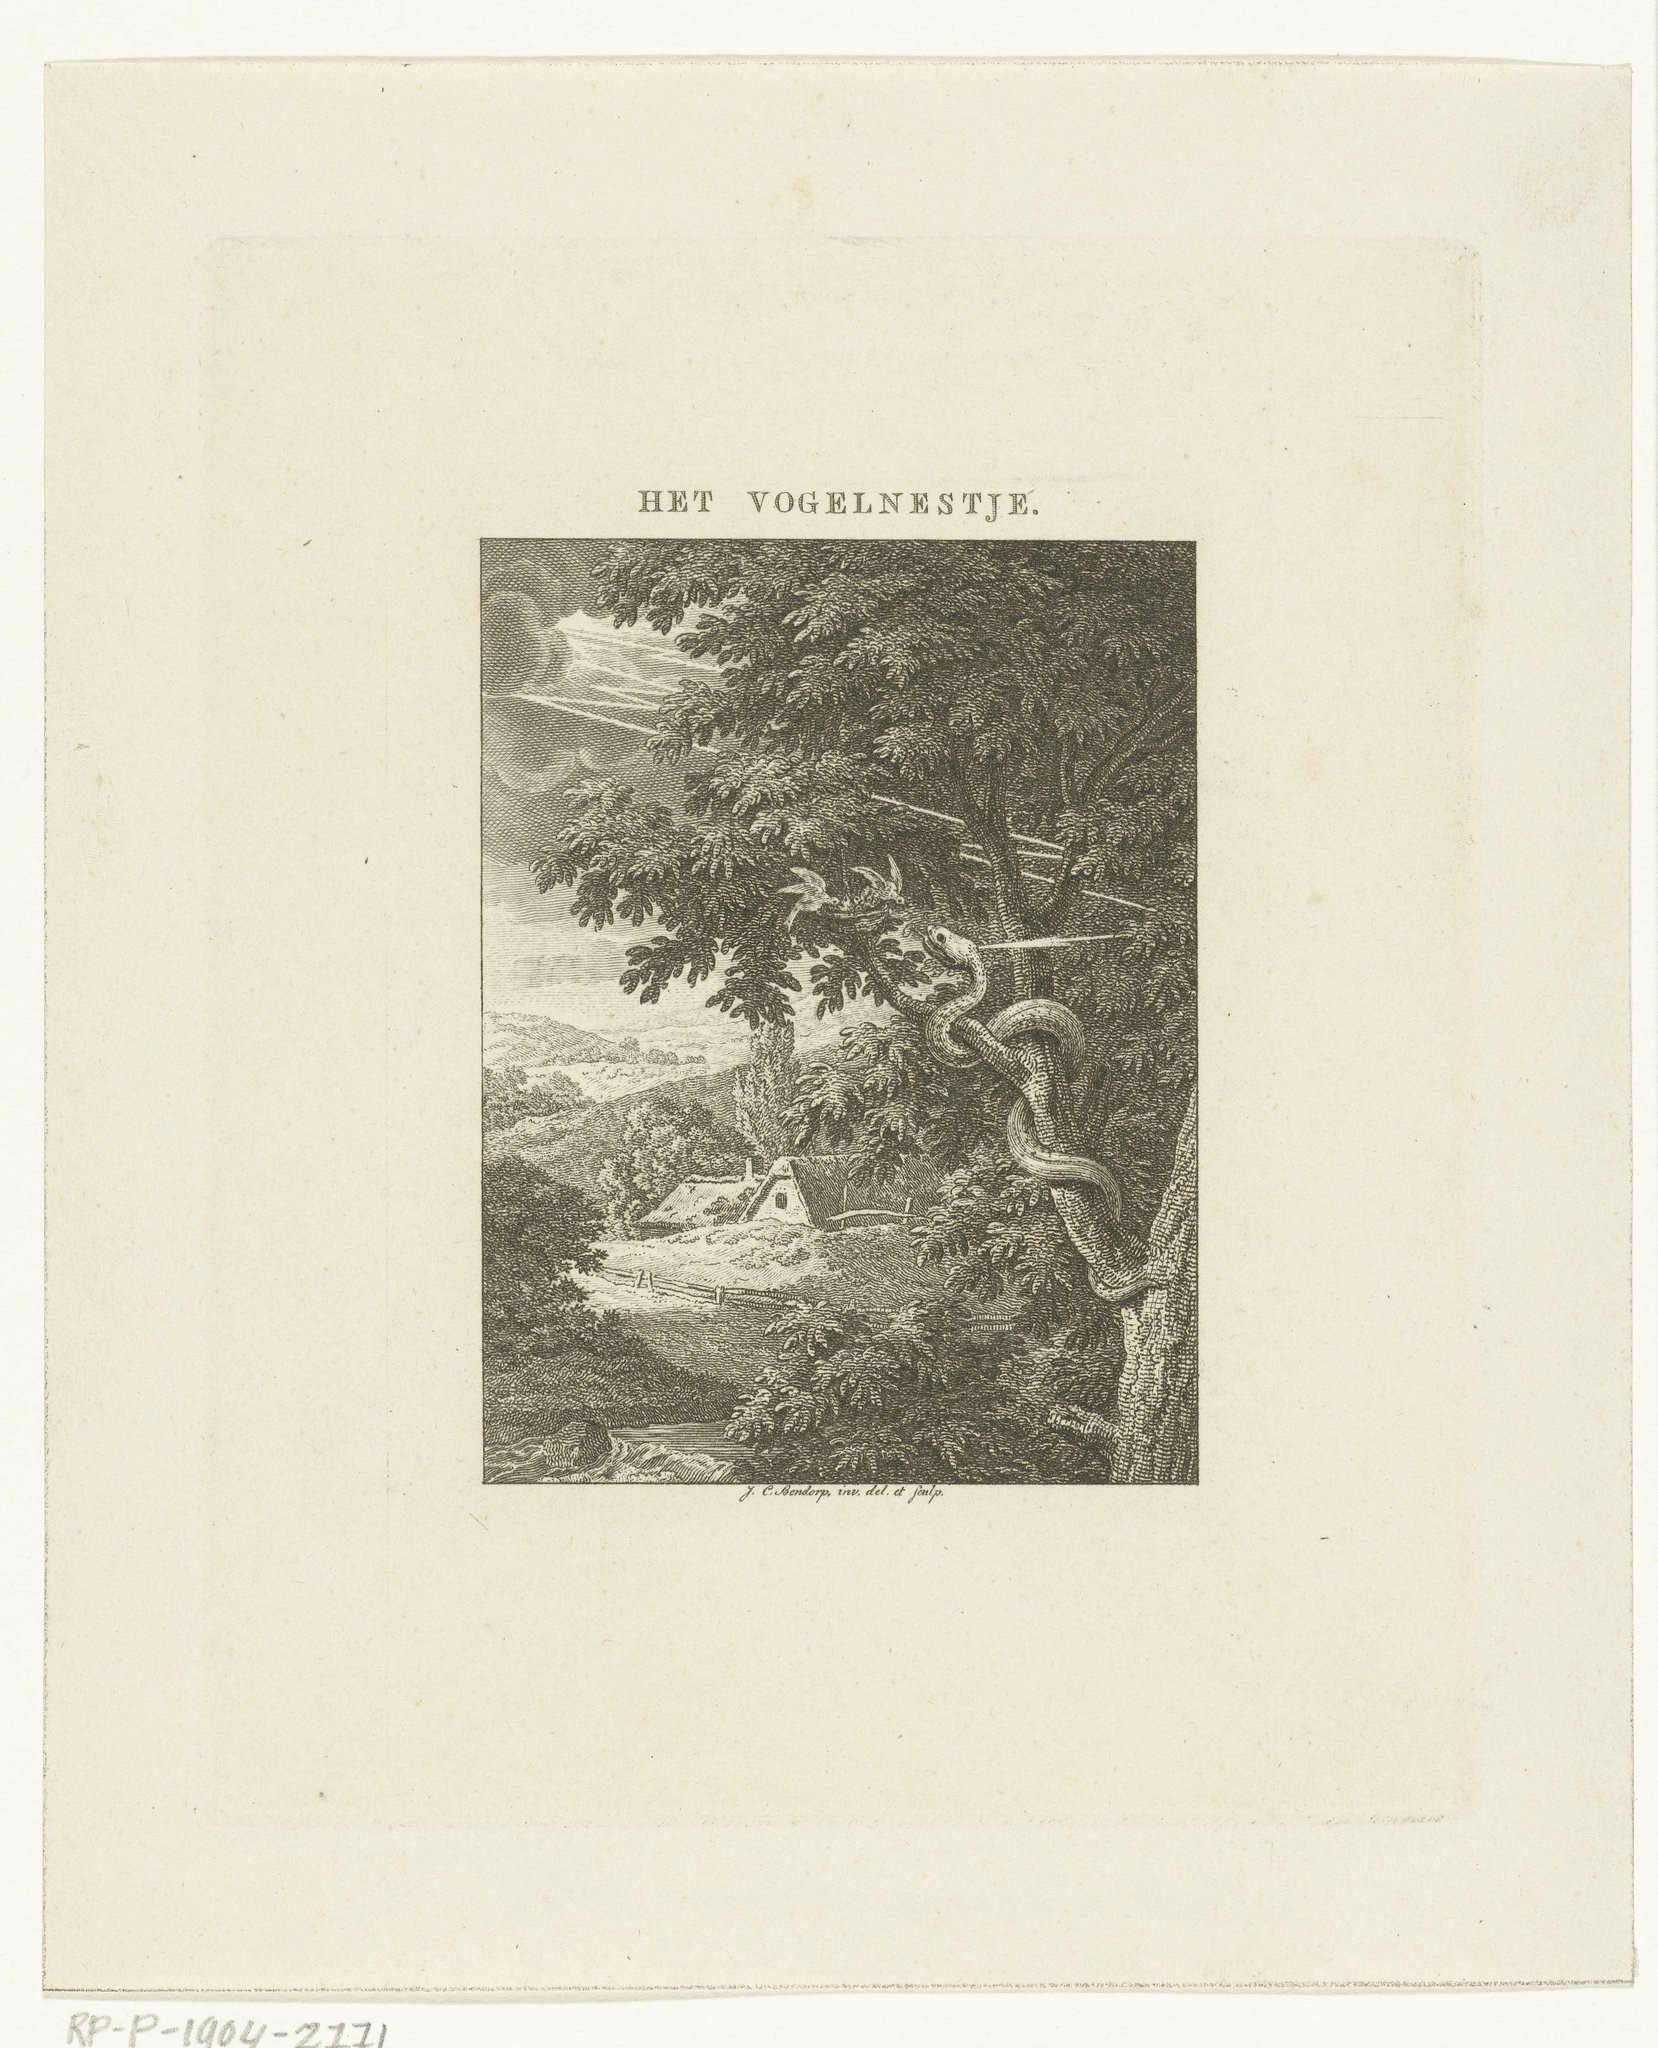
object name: book illustration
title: Het vogelnestje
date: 1776-1847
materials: paper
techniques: etching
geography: netherlands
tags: animals (+ feeding and care of young), fabulous animals (sometimes wrongly called 'grotesques'); 'mostri' (ripa) (+ nest, den, burrow)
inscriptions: collector's mark: Lugt 2228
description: Prent uit: Nederlandsche muzen-almanak, Johannes Immerzeel (uitgever), Amsterdam 1819-1847